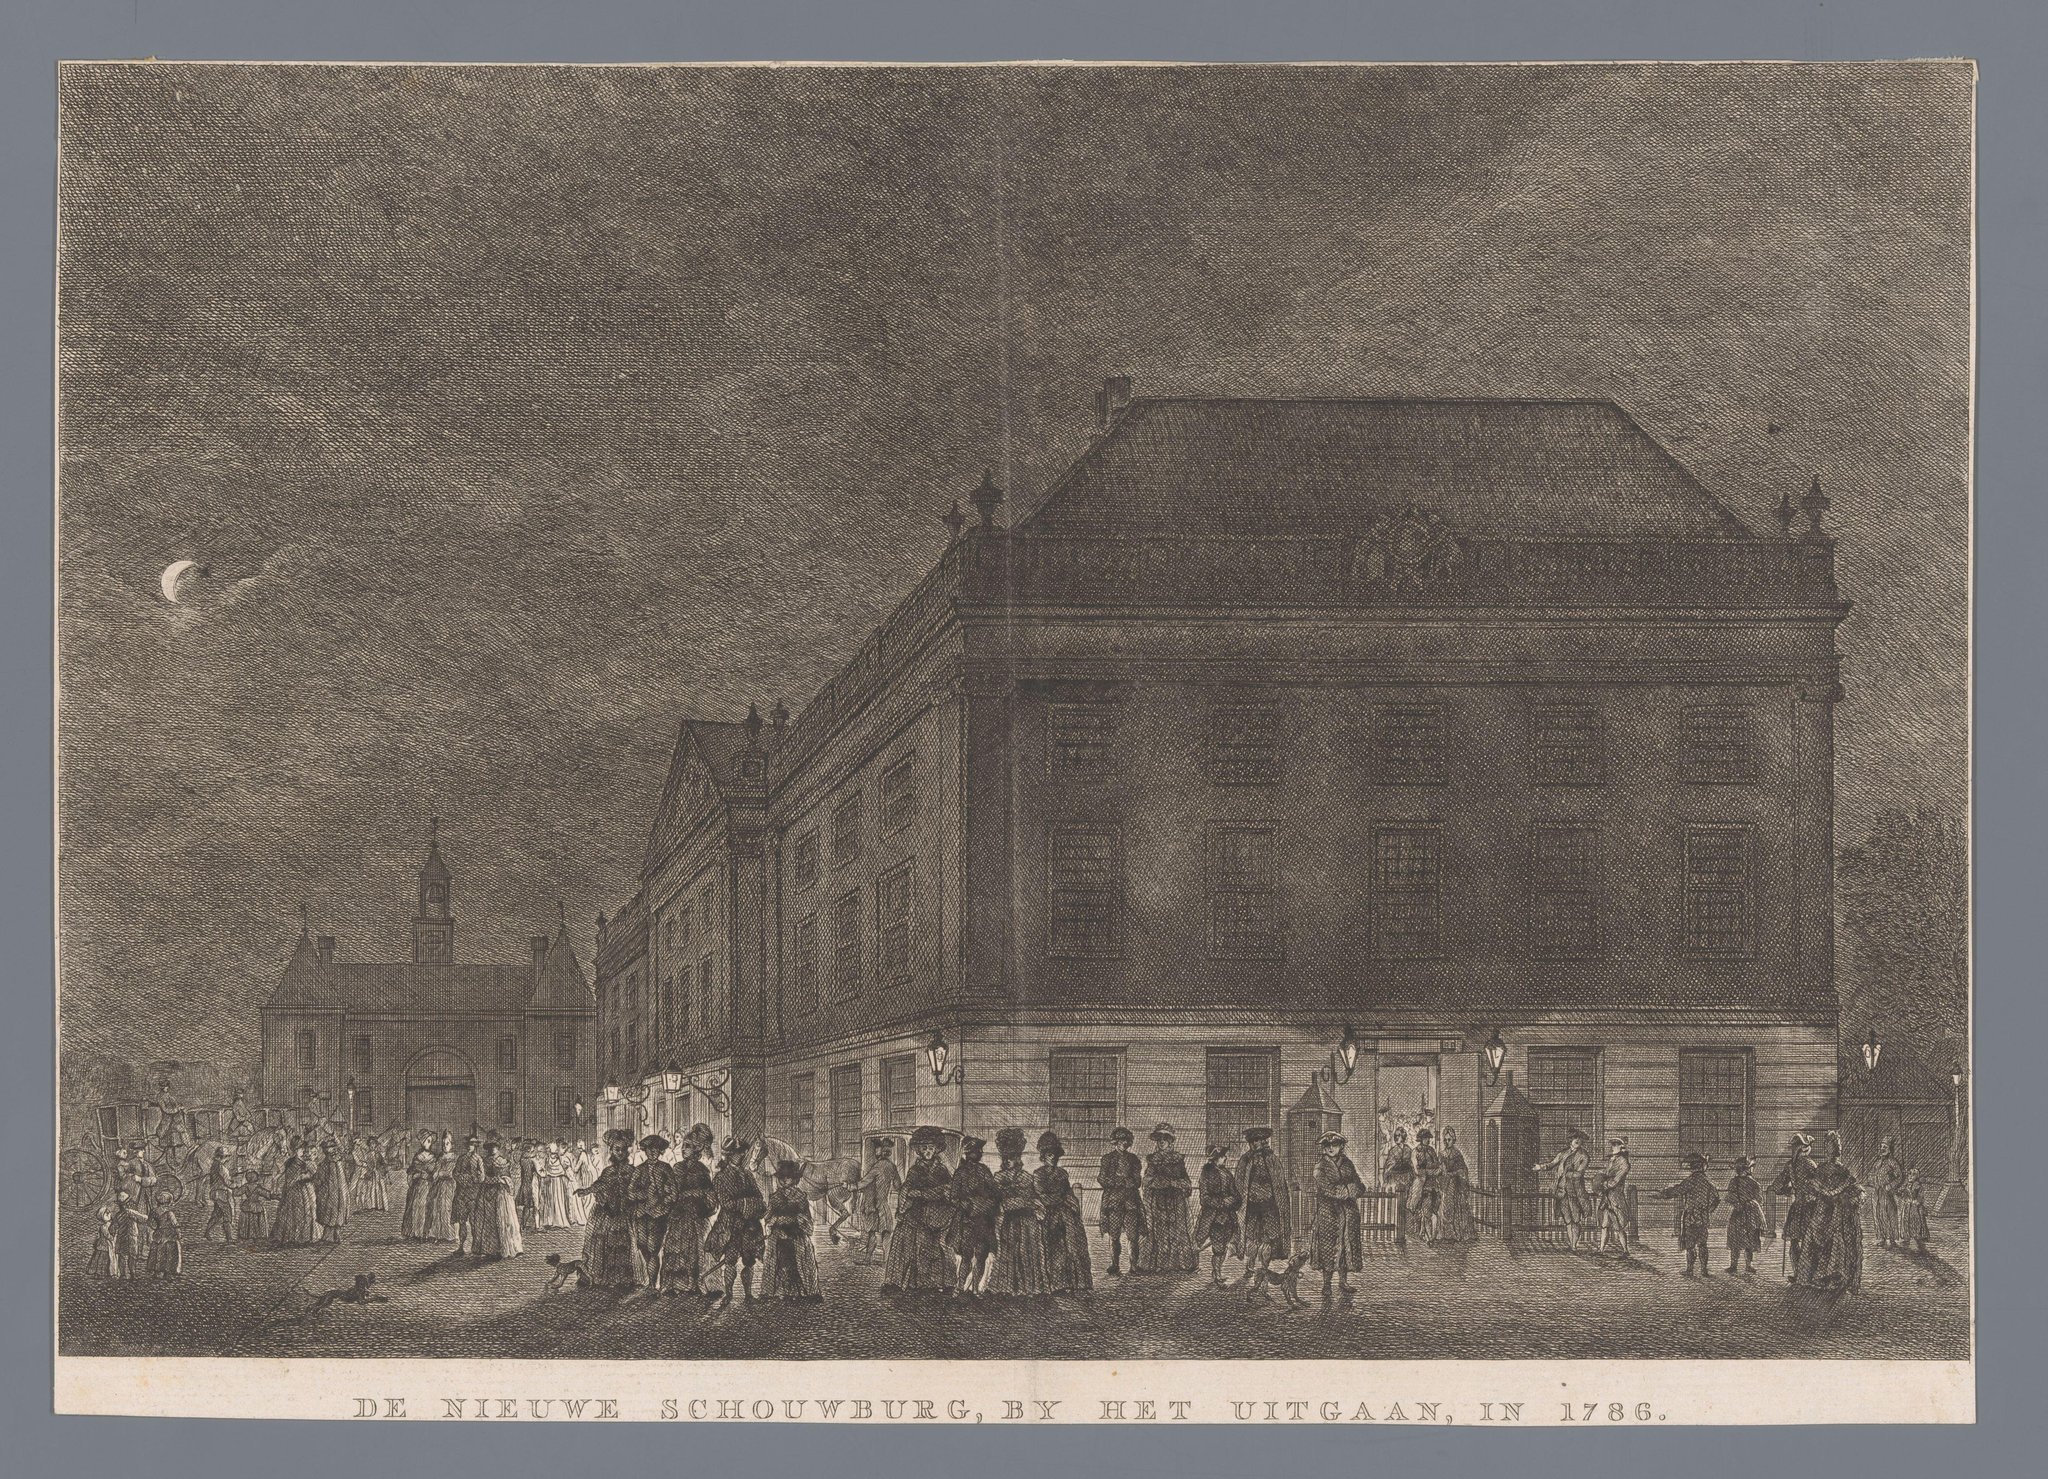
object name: print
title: De nieuwe schouwburg, by het uitgaan, in 1786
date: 1789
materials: paper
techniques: engraving, etching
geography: amsterdam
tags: concert hall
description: Prent uit: Stijl, Simon. Amsterdam in zyne geschiedenissen, voorregten, koophandel (...). Amsterdam: Petrus Conradi, Harlingen: Volkert van der Plaats, 1789, dl. 4, na p. 498.